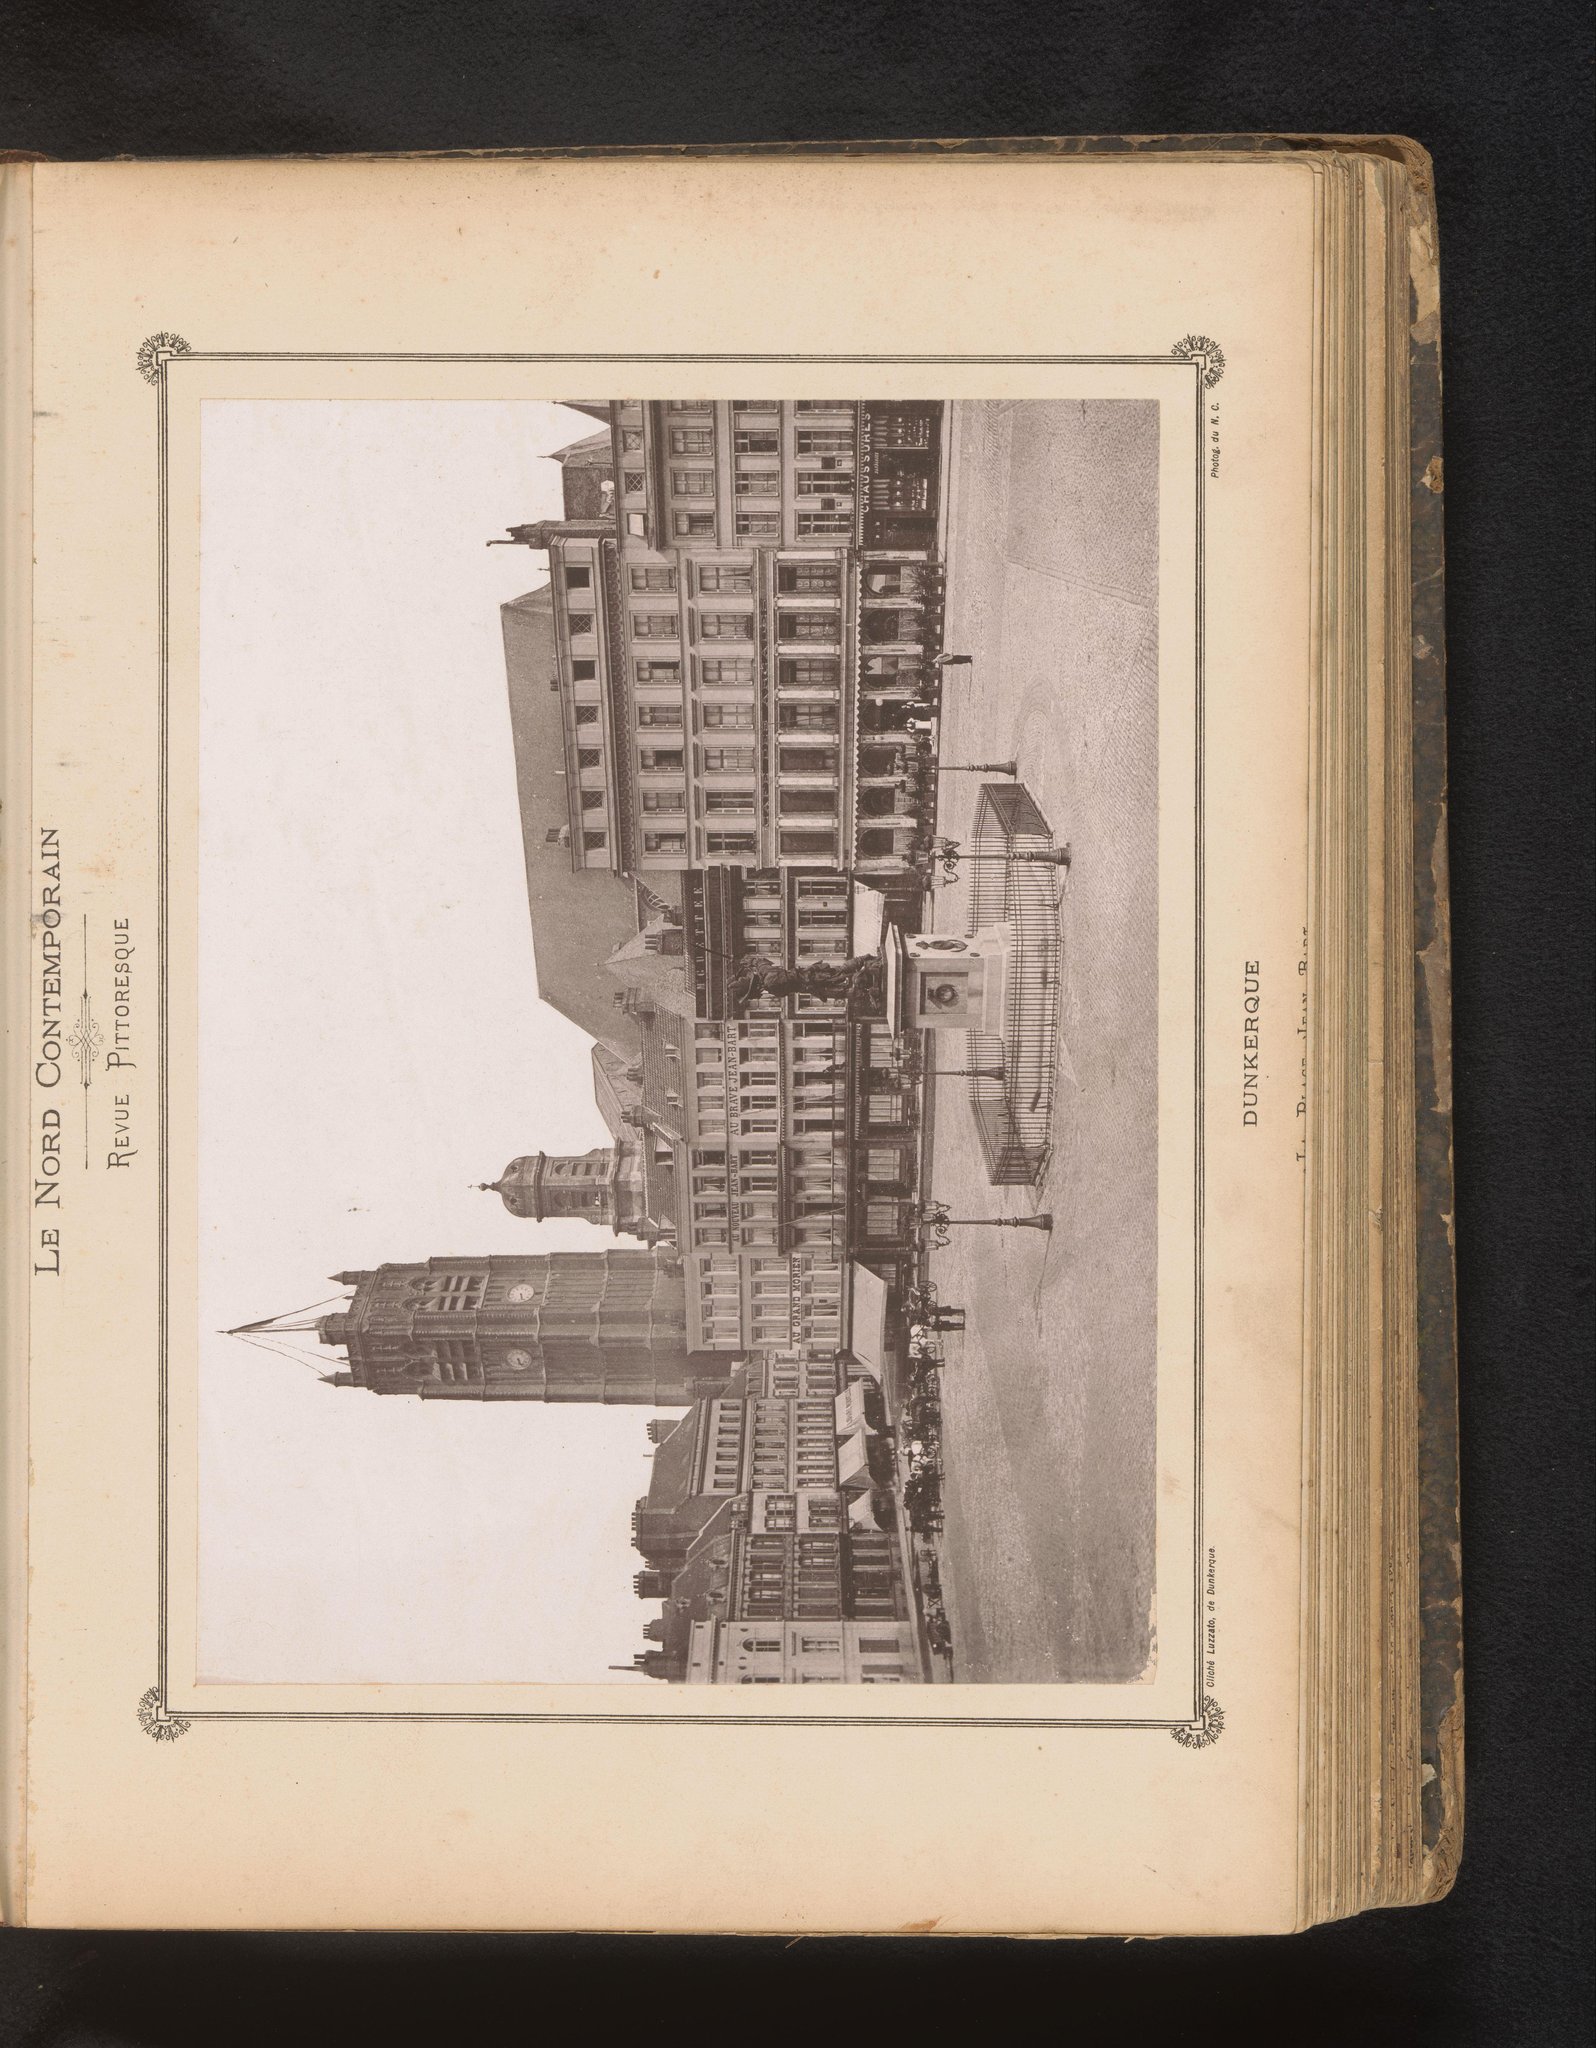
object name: page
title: Dunkerque, [La Place Jean Bart]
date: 1877-1882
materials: paper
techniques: photograph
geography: dunkirk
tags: square, place, circus, etc., monument, statue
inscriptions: inscription: ‘Le Nord Contemporain/ Revue Pittoresque’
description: Prent op vijfde ongenummerde pagina na pagina 352.